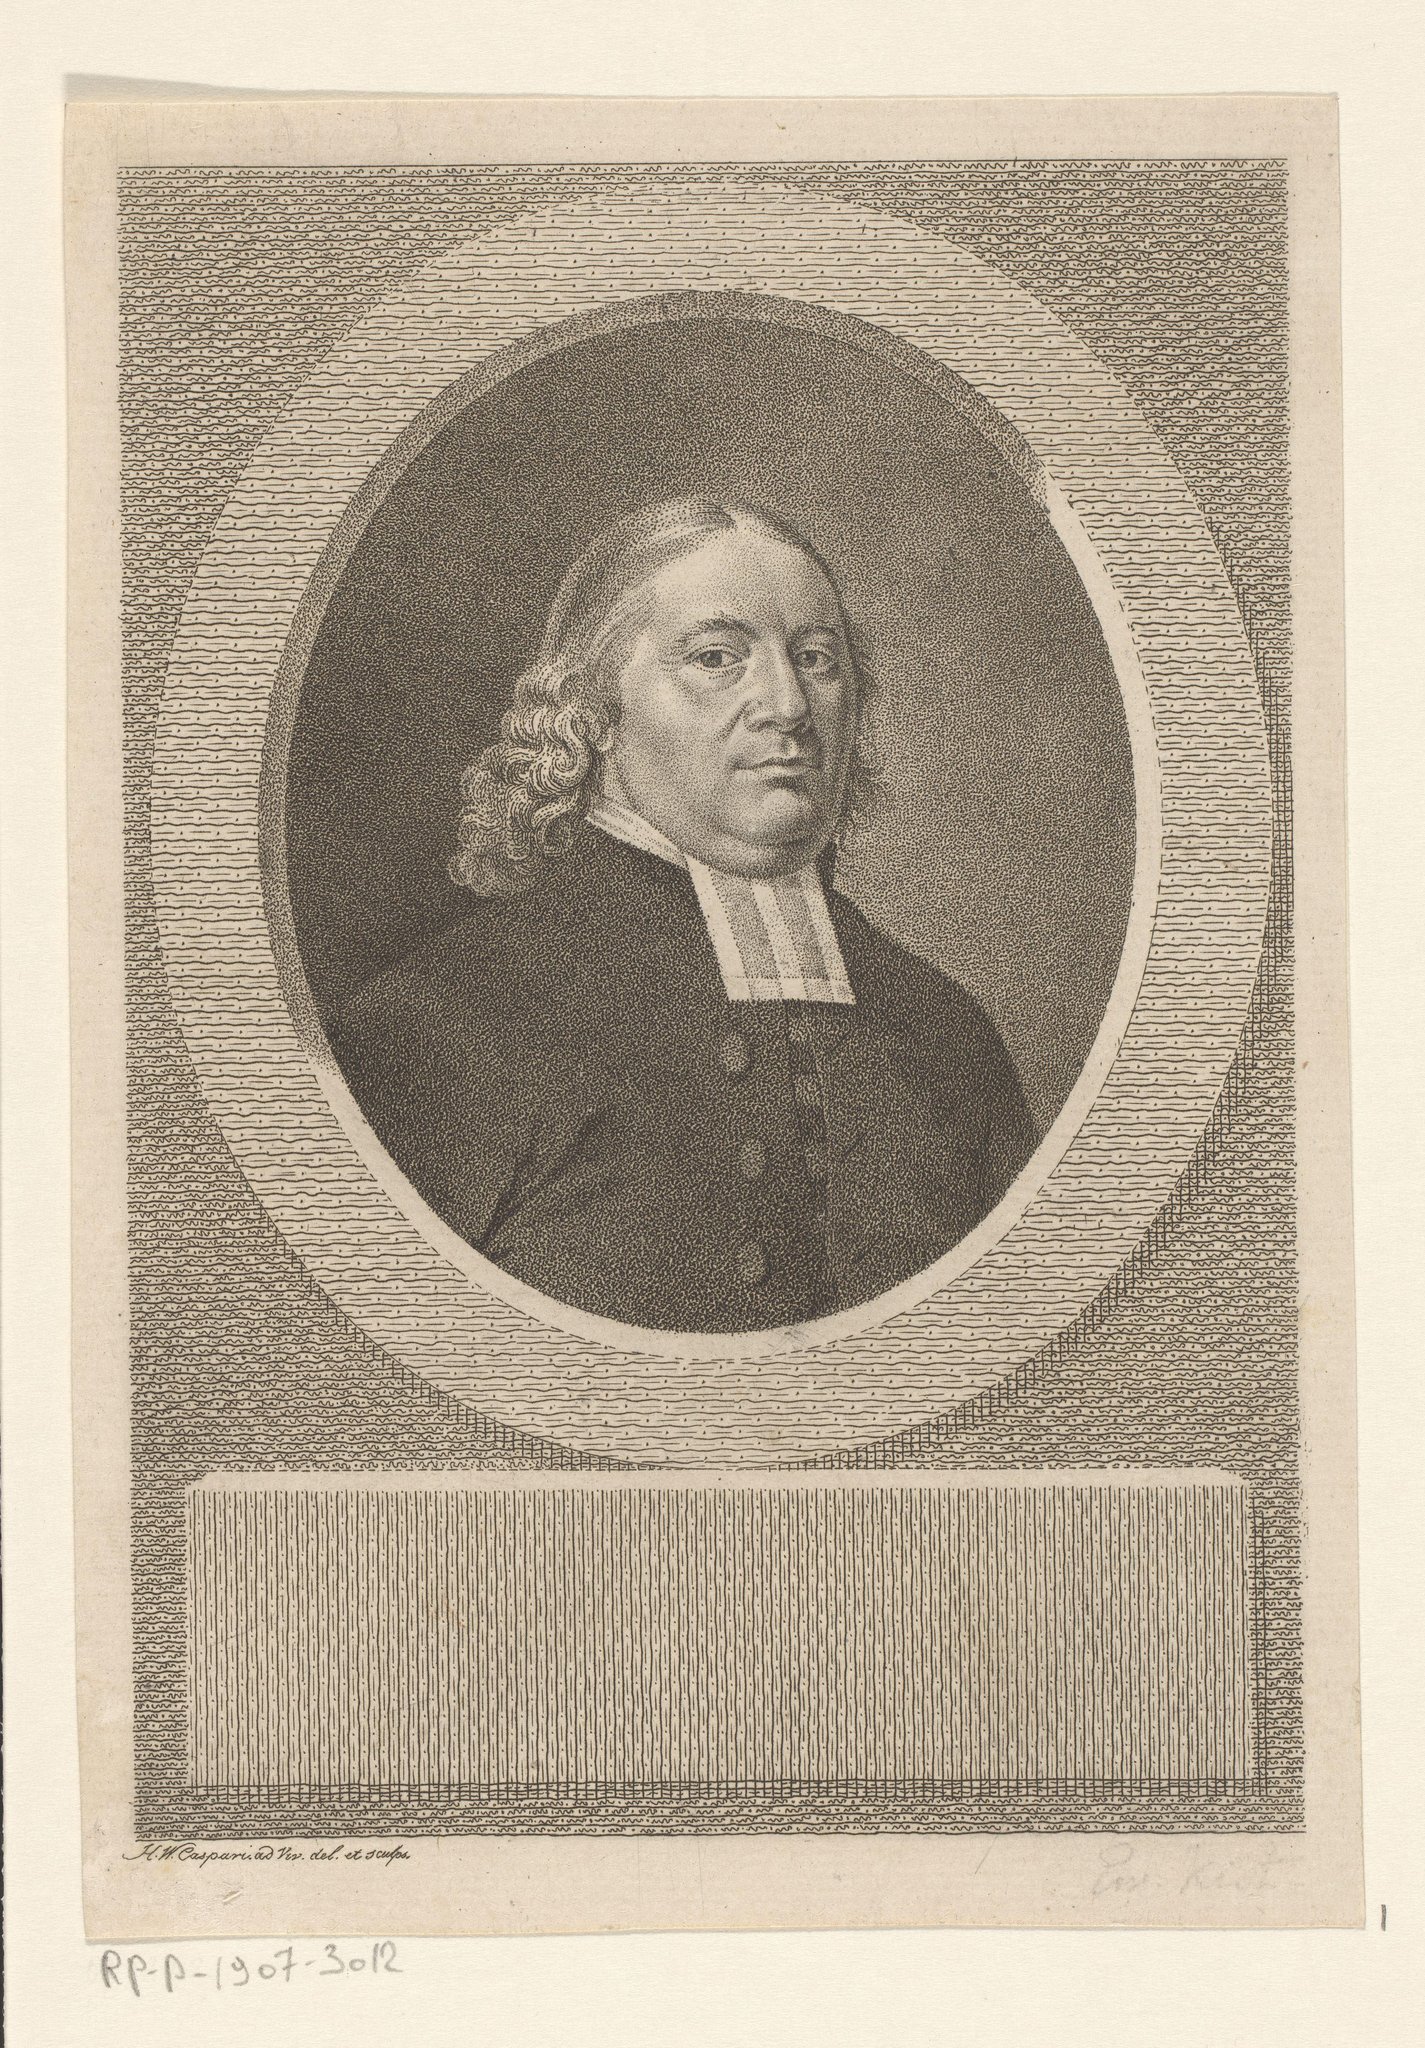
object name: print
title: Portret van Ewaldus Kist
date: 1780-1829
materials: paper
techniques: etching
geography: amsterdam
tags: dordrecht, ewaldus kist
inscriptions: collector's mark: Lugt 2166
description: Portret in ovale lijst van Ewaldus Kist, een Dordrechtse prediker. Buste naar rechts. Kist draagt een predikersgewaad.